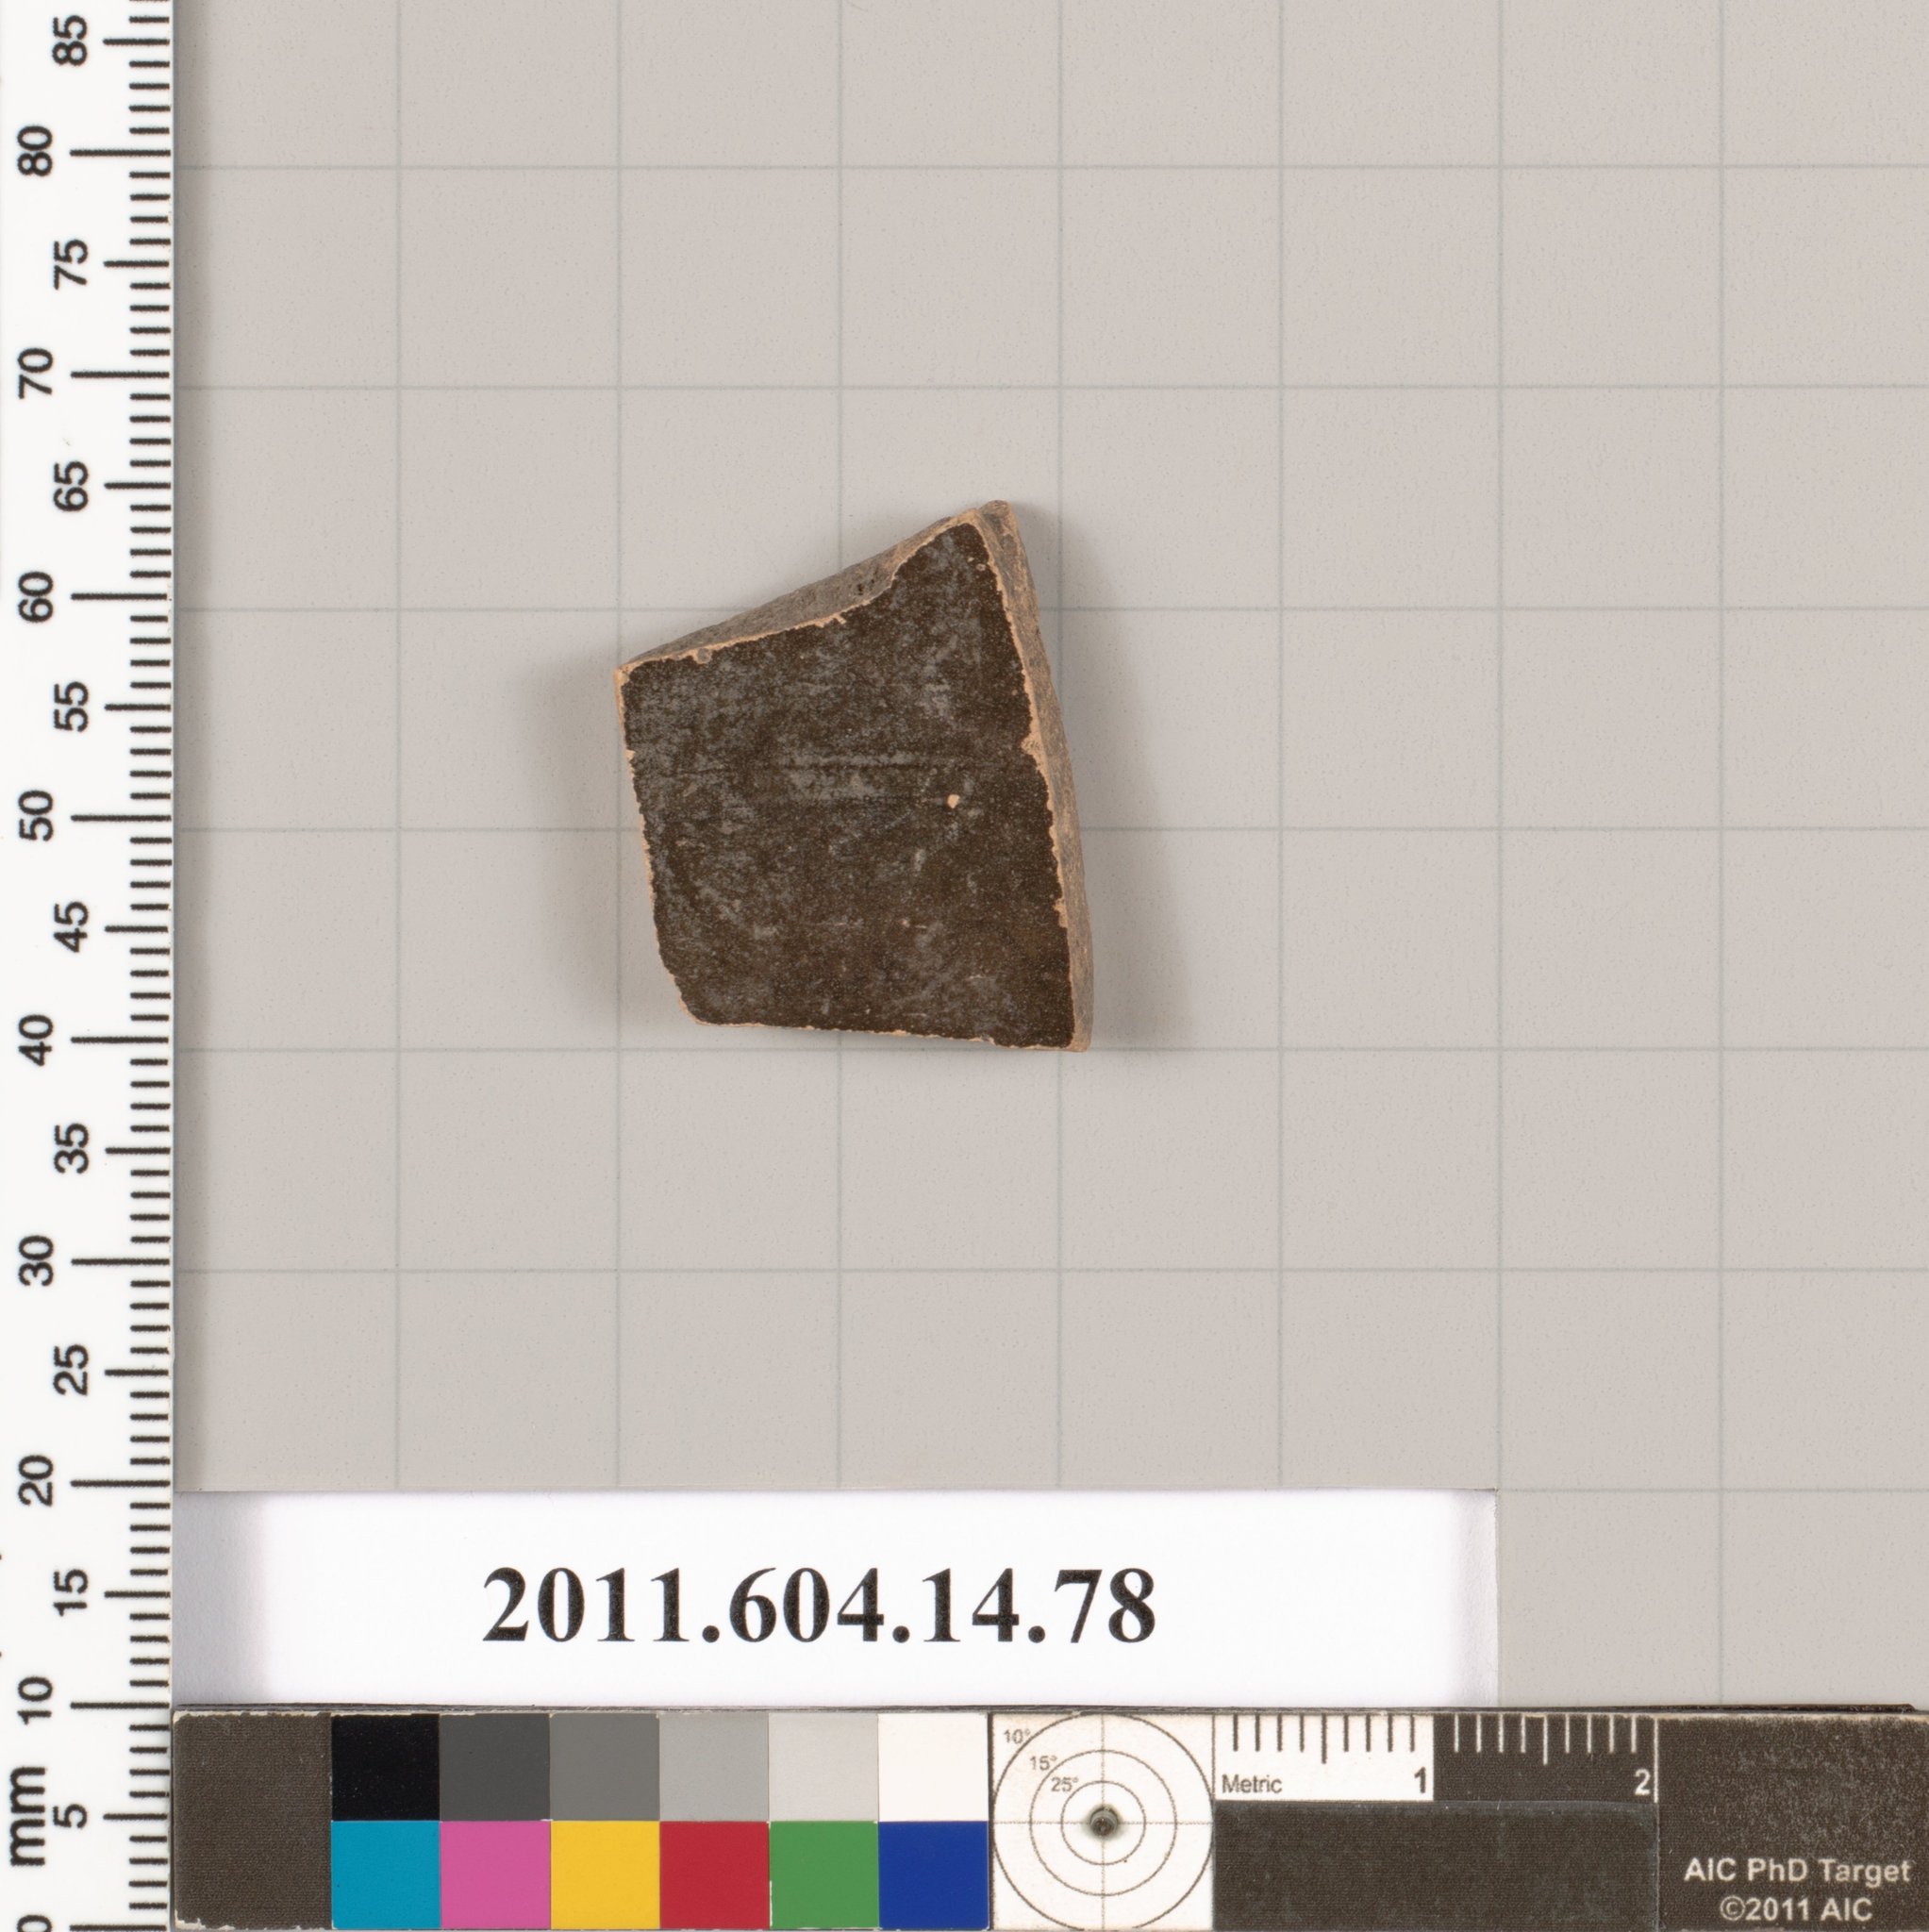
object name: undetermined open shape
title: Terracotta fragment of an open shape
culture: unknown fabric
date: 300-201 BCE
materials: terracotta